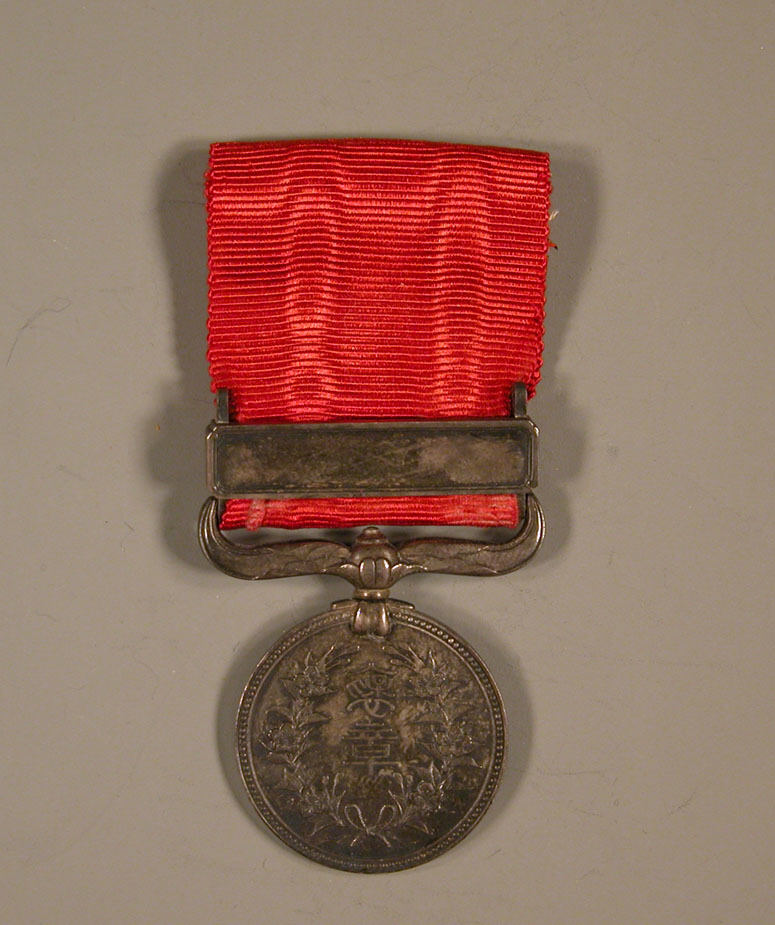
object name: medal of honor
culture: japanese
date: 1867-1900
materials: ribbon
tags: emblems